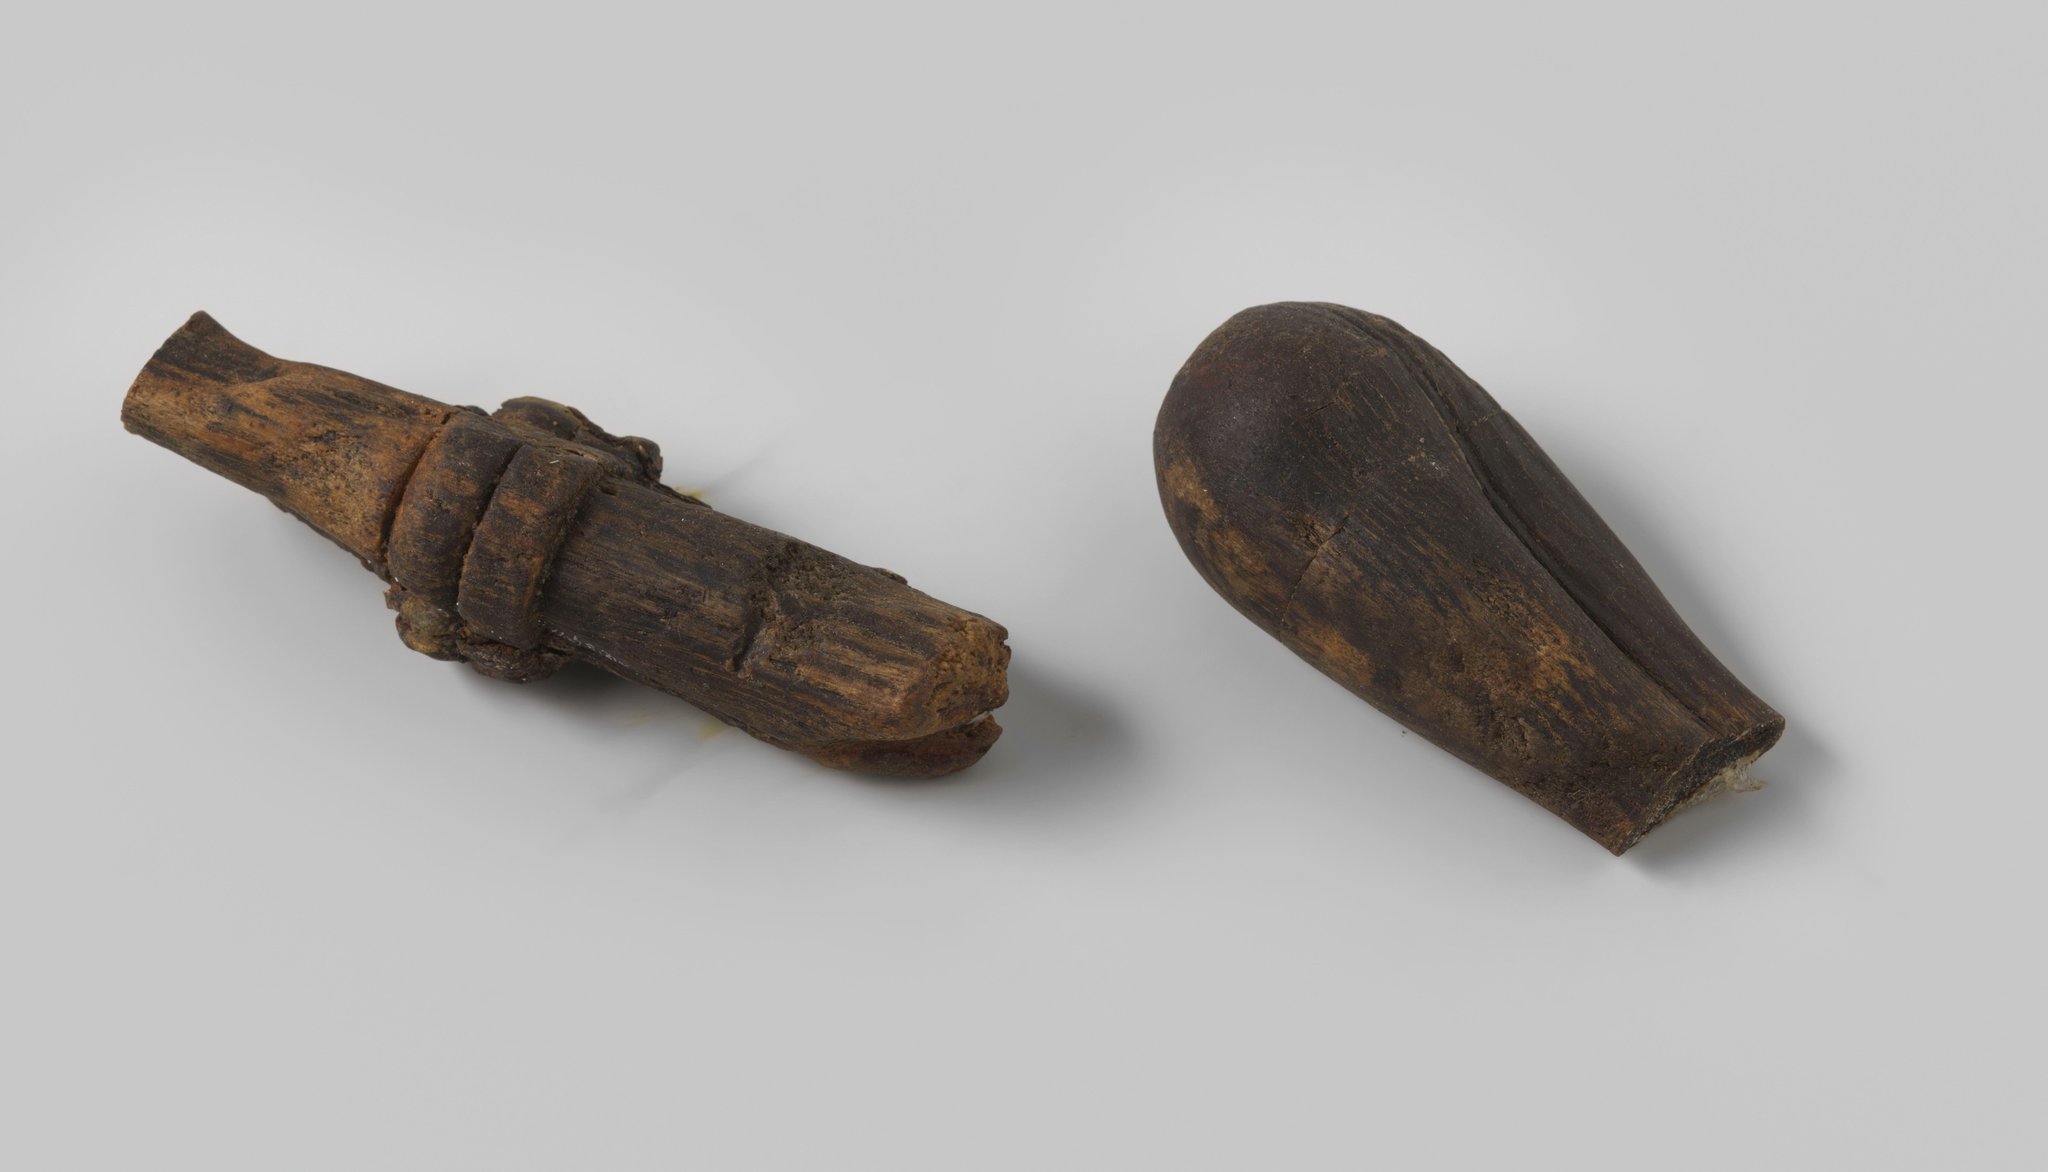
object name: belaying pin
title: Fragmenten korvijnagel uit het wrak van de Oost-Indiëvaarder Hollandia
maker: Anonymous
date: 1700-1743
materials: wood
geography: netherlands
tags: verenigde oostindische compagnie, hollandia (schip), annet